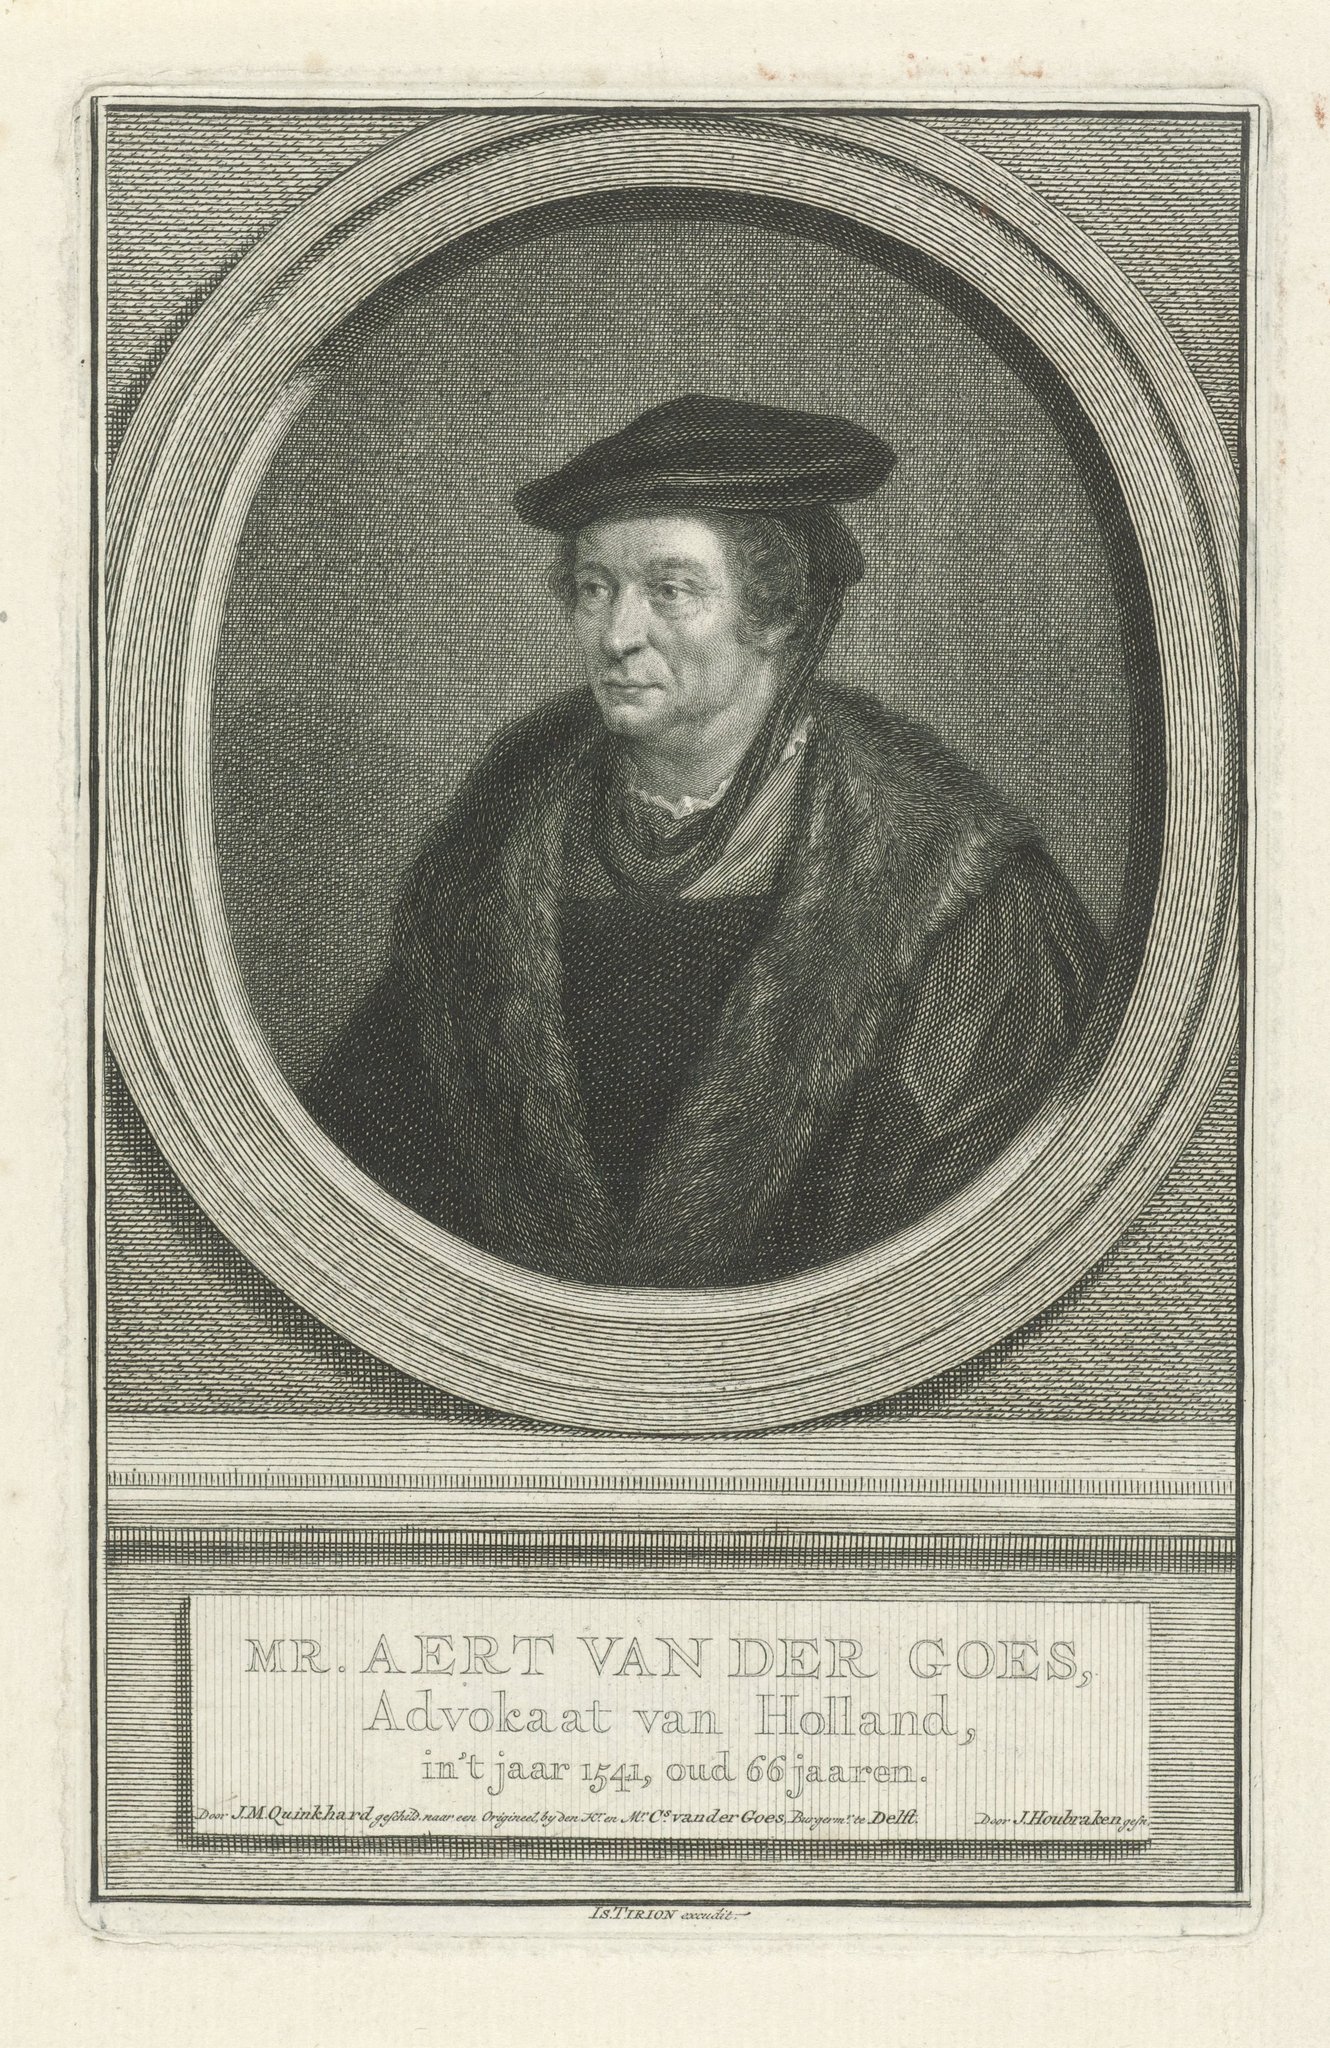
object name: print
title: Portret van Aart van der Goes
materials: paper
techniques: engraving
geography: amsterdam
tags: historical persons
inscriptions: collector's mark: Lugt 2228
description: Portret van Aart van der Goes in een ovaal. Het portret rust op een plint met daarop zijn naam en gegevens in drie regels in het Nederlands.